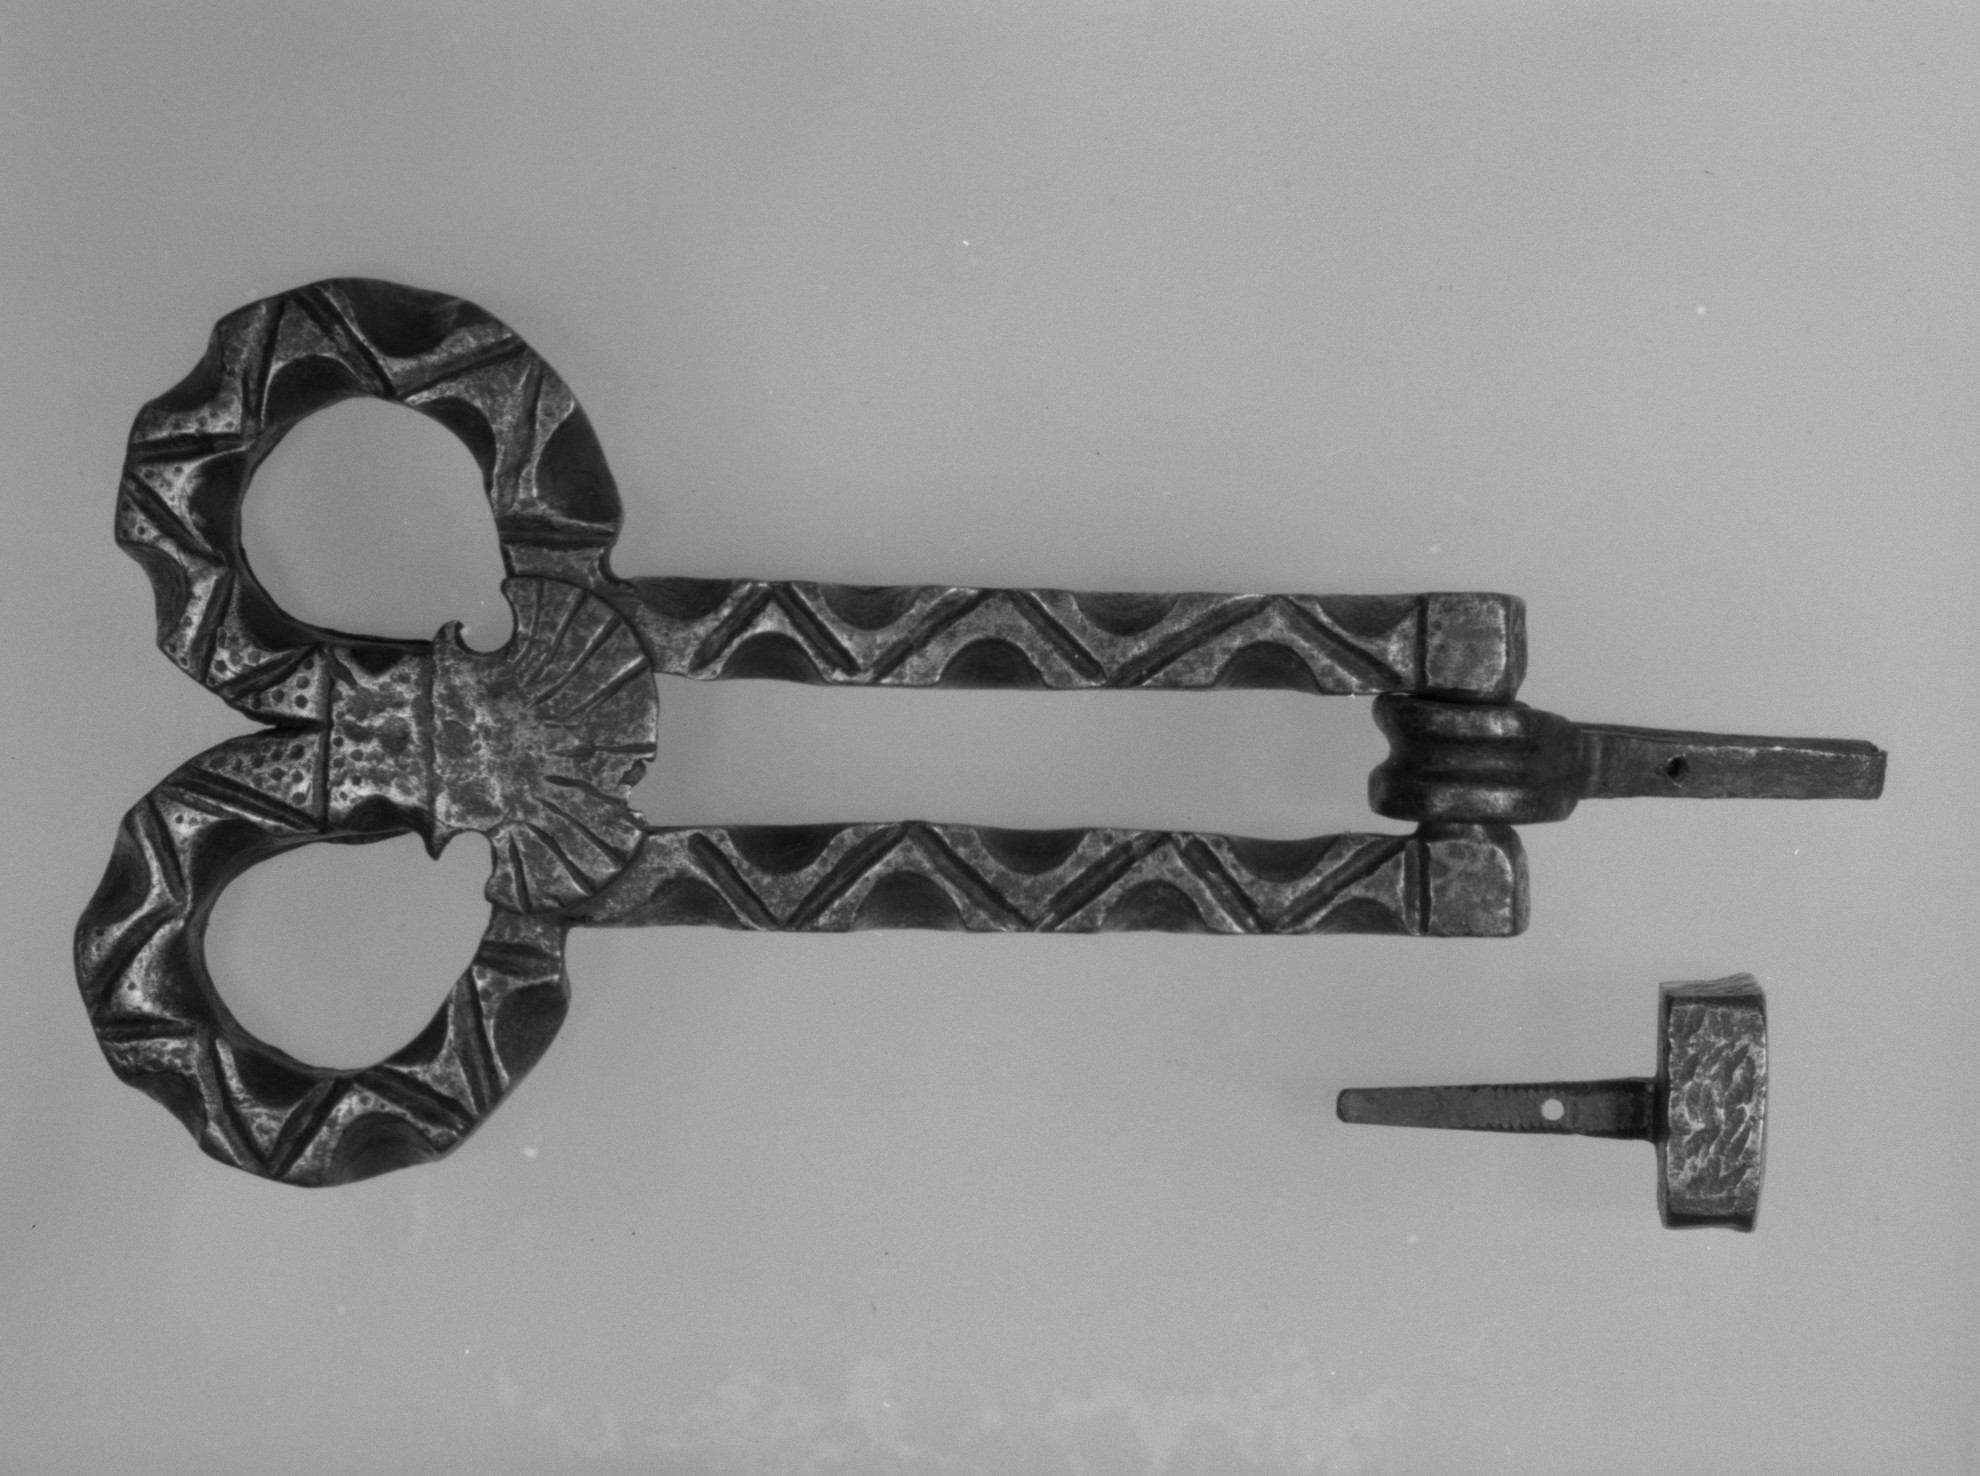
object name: door knocker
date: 1601-1633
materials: iron